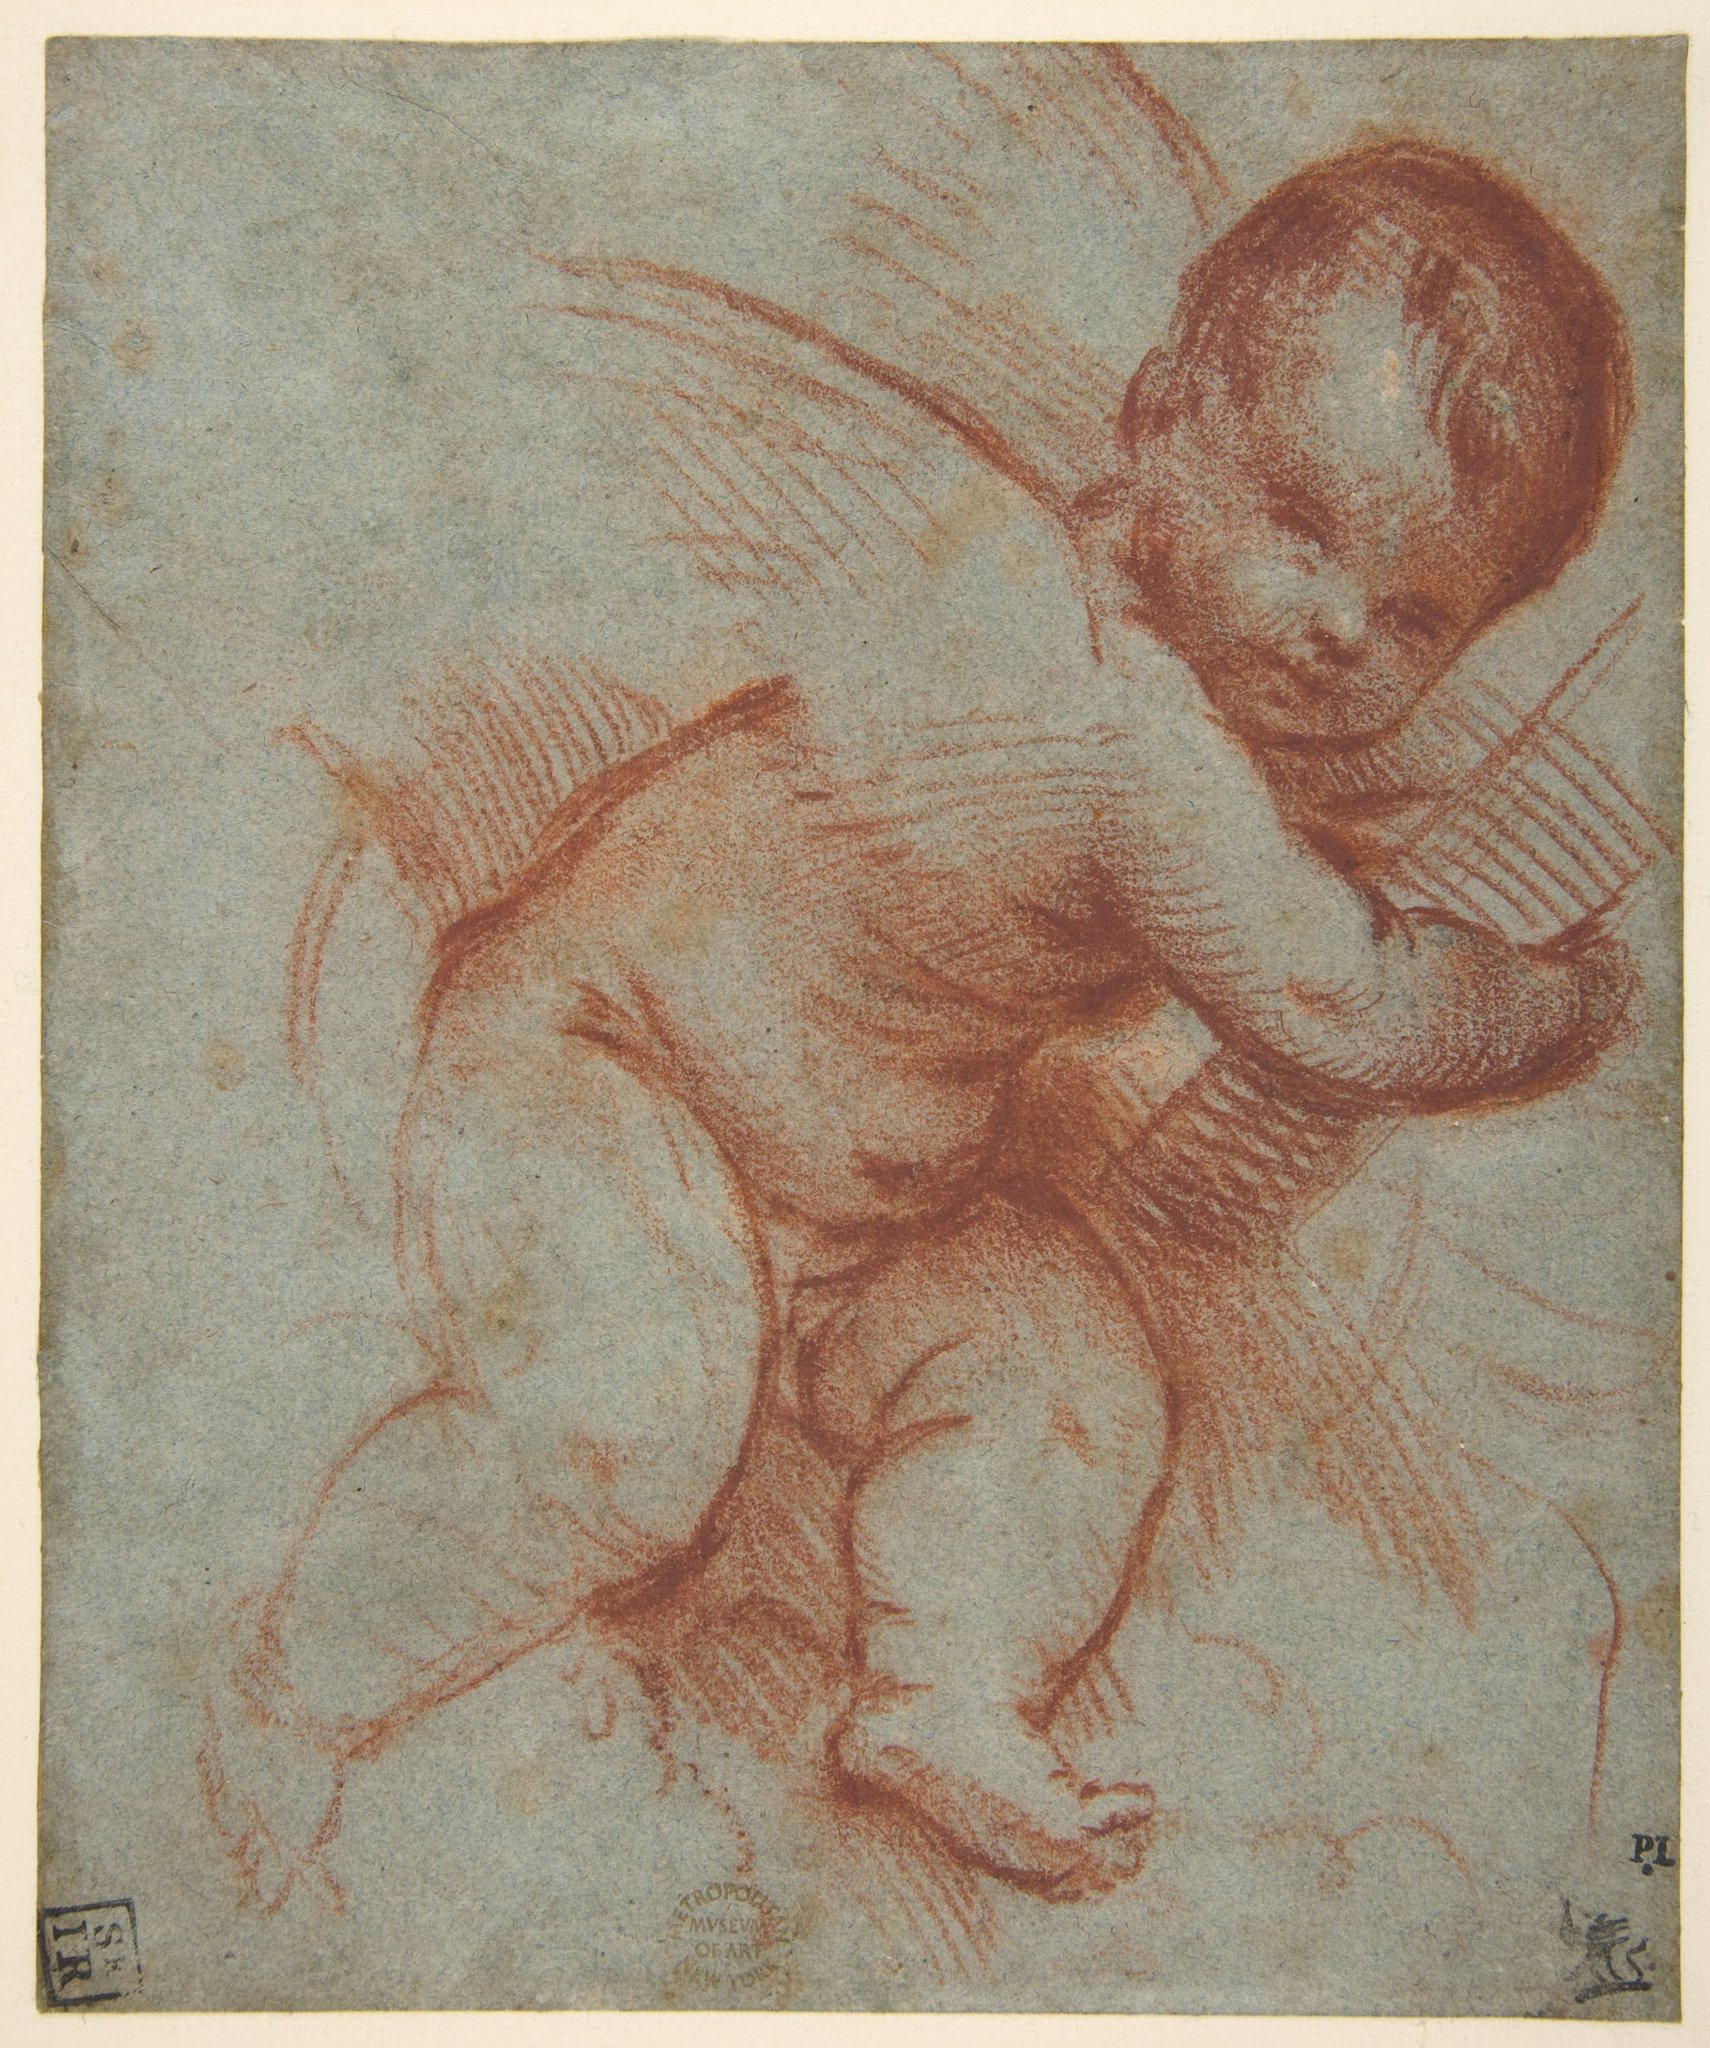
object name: drawing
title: Winged Putto Holding the Base of a Cross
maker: titian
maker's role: artist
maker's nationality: italian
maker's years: 1485-1576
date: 1477-1510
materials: chalk, paper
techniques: heightening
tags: putti